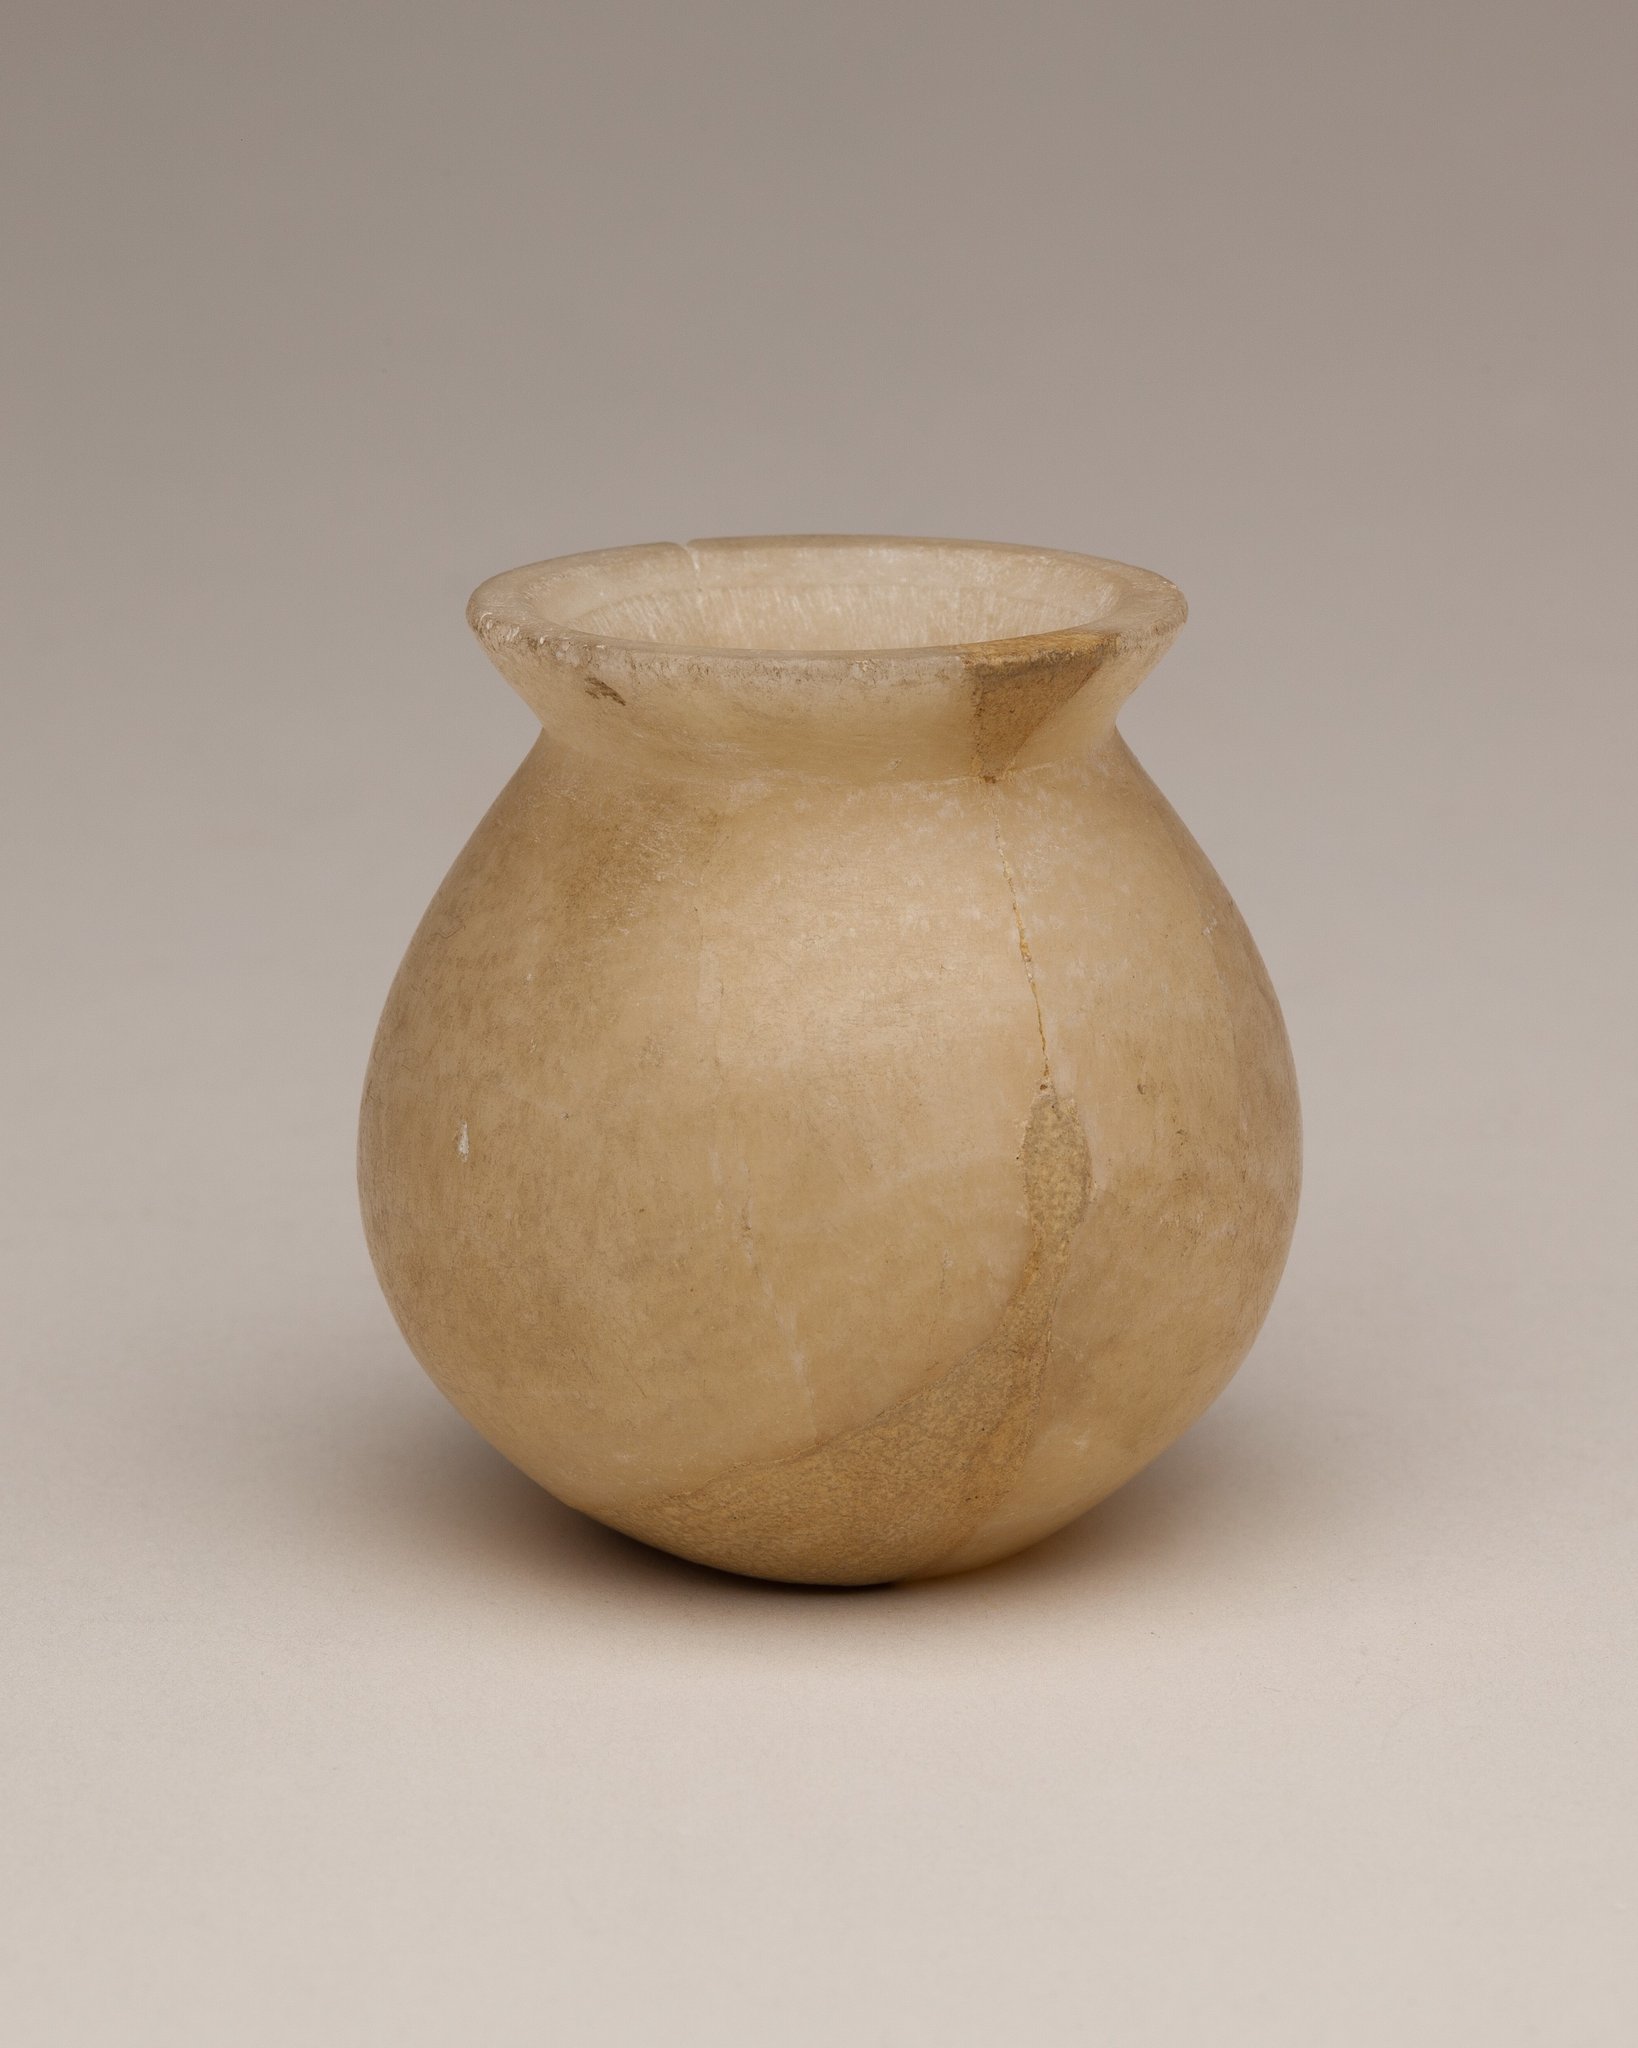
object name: kohl jar lid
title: Kohl jar and lid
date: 1981-1640 BCE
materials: stone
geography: egypt